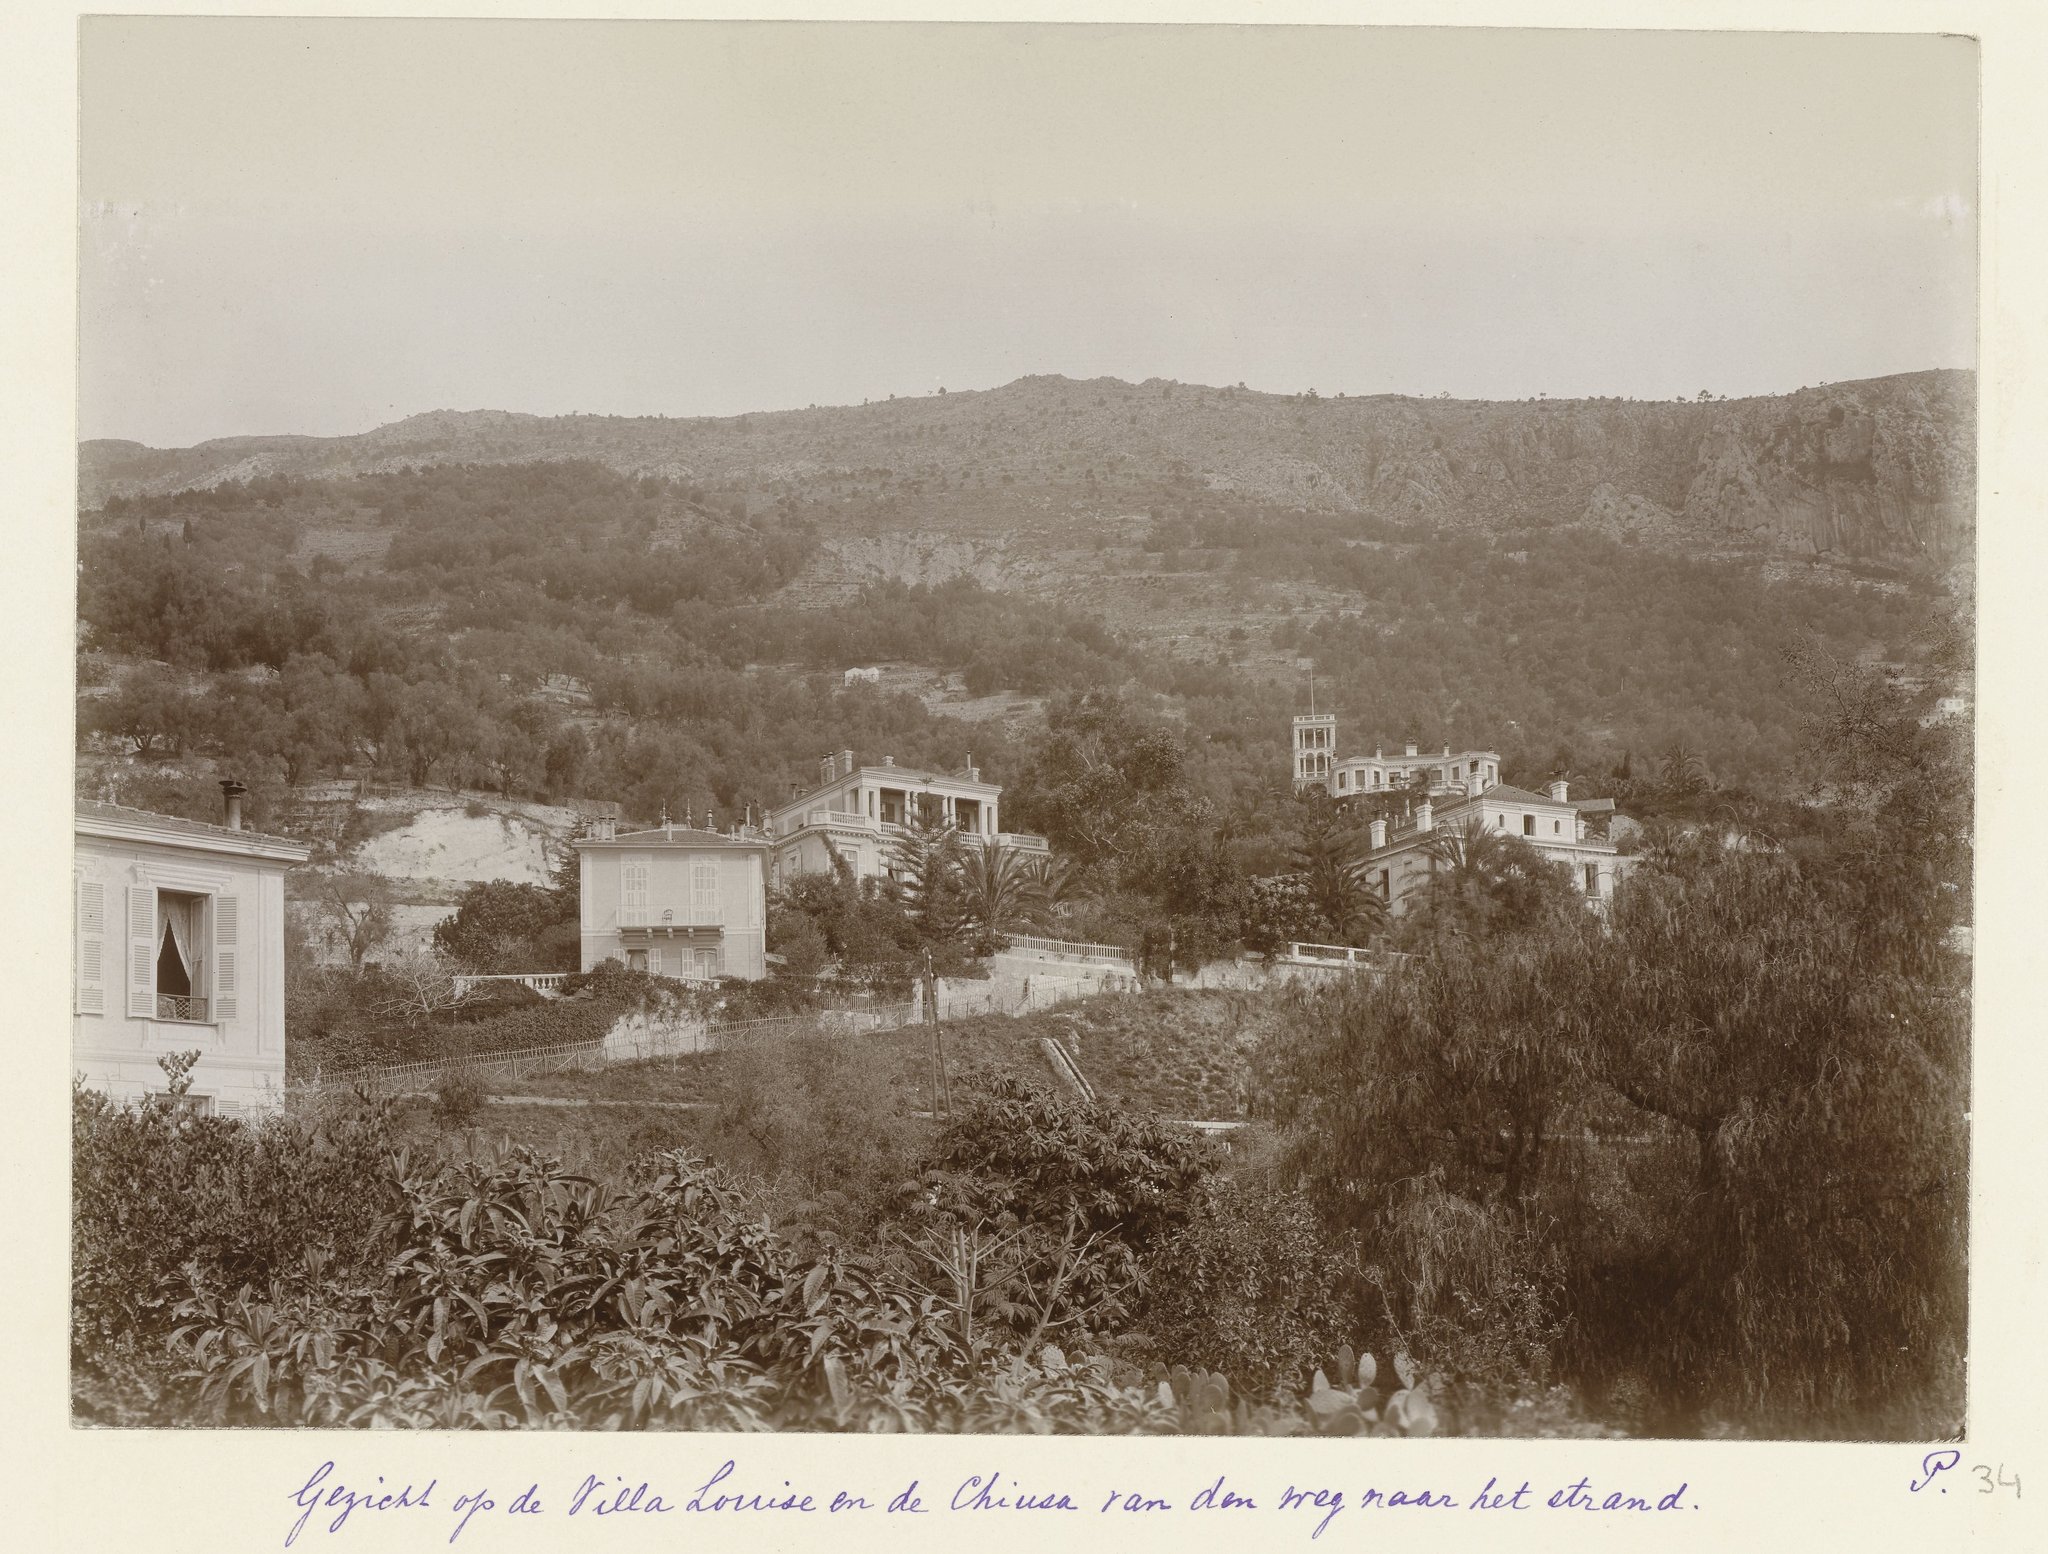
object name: photograph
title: Gezicht op Villa Louise van het station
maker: henry pauw van wieldrecht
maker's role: fotograaf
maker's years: 1863-1912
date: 1886-1896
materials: cardboard, photographic support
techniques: albumen print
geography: france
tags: menton